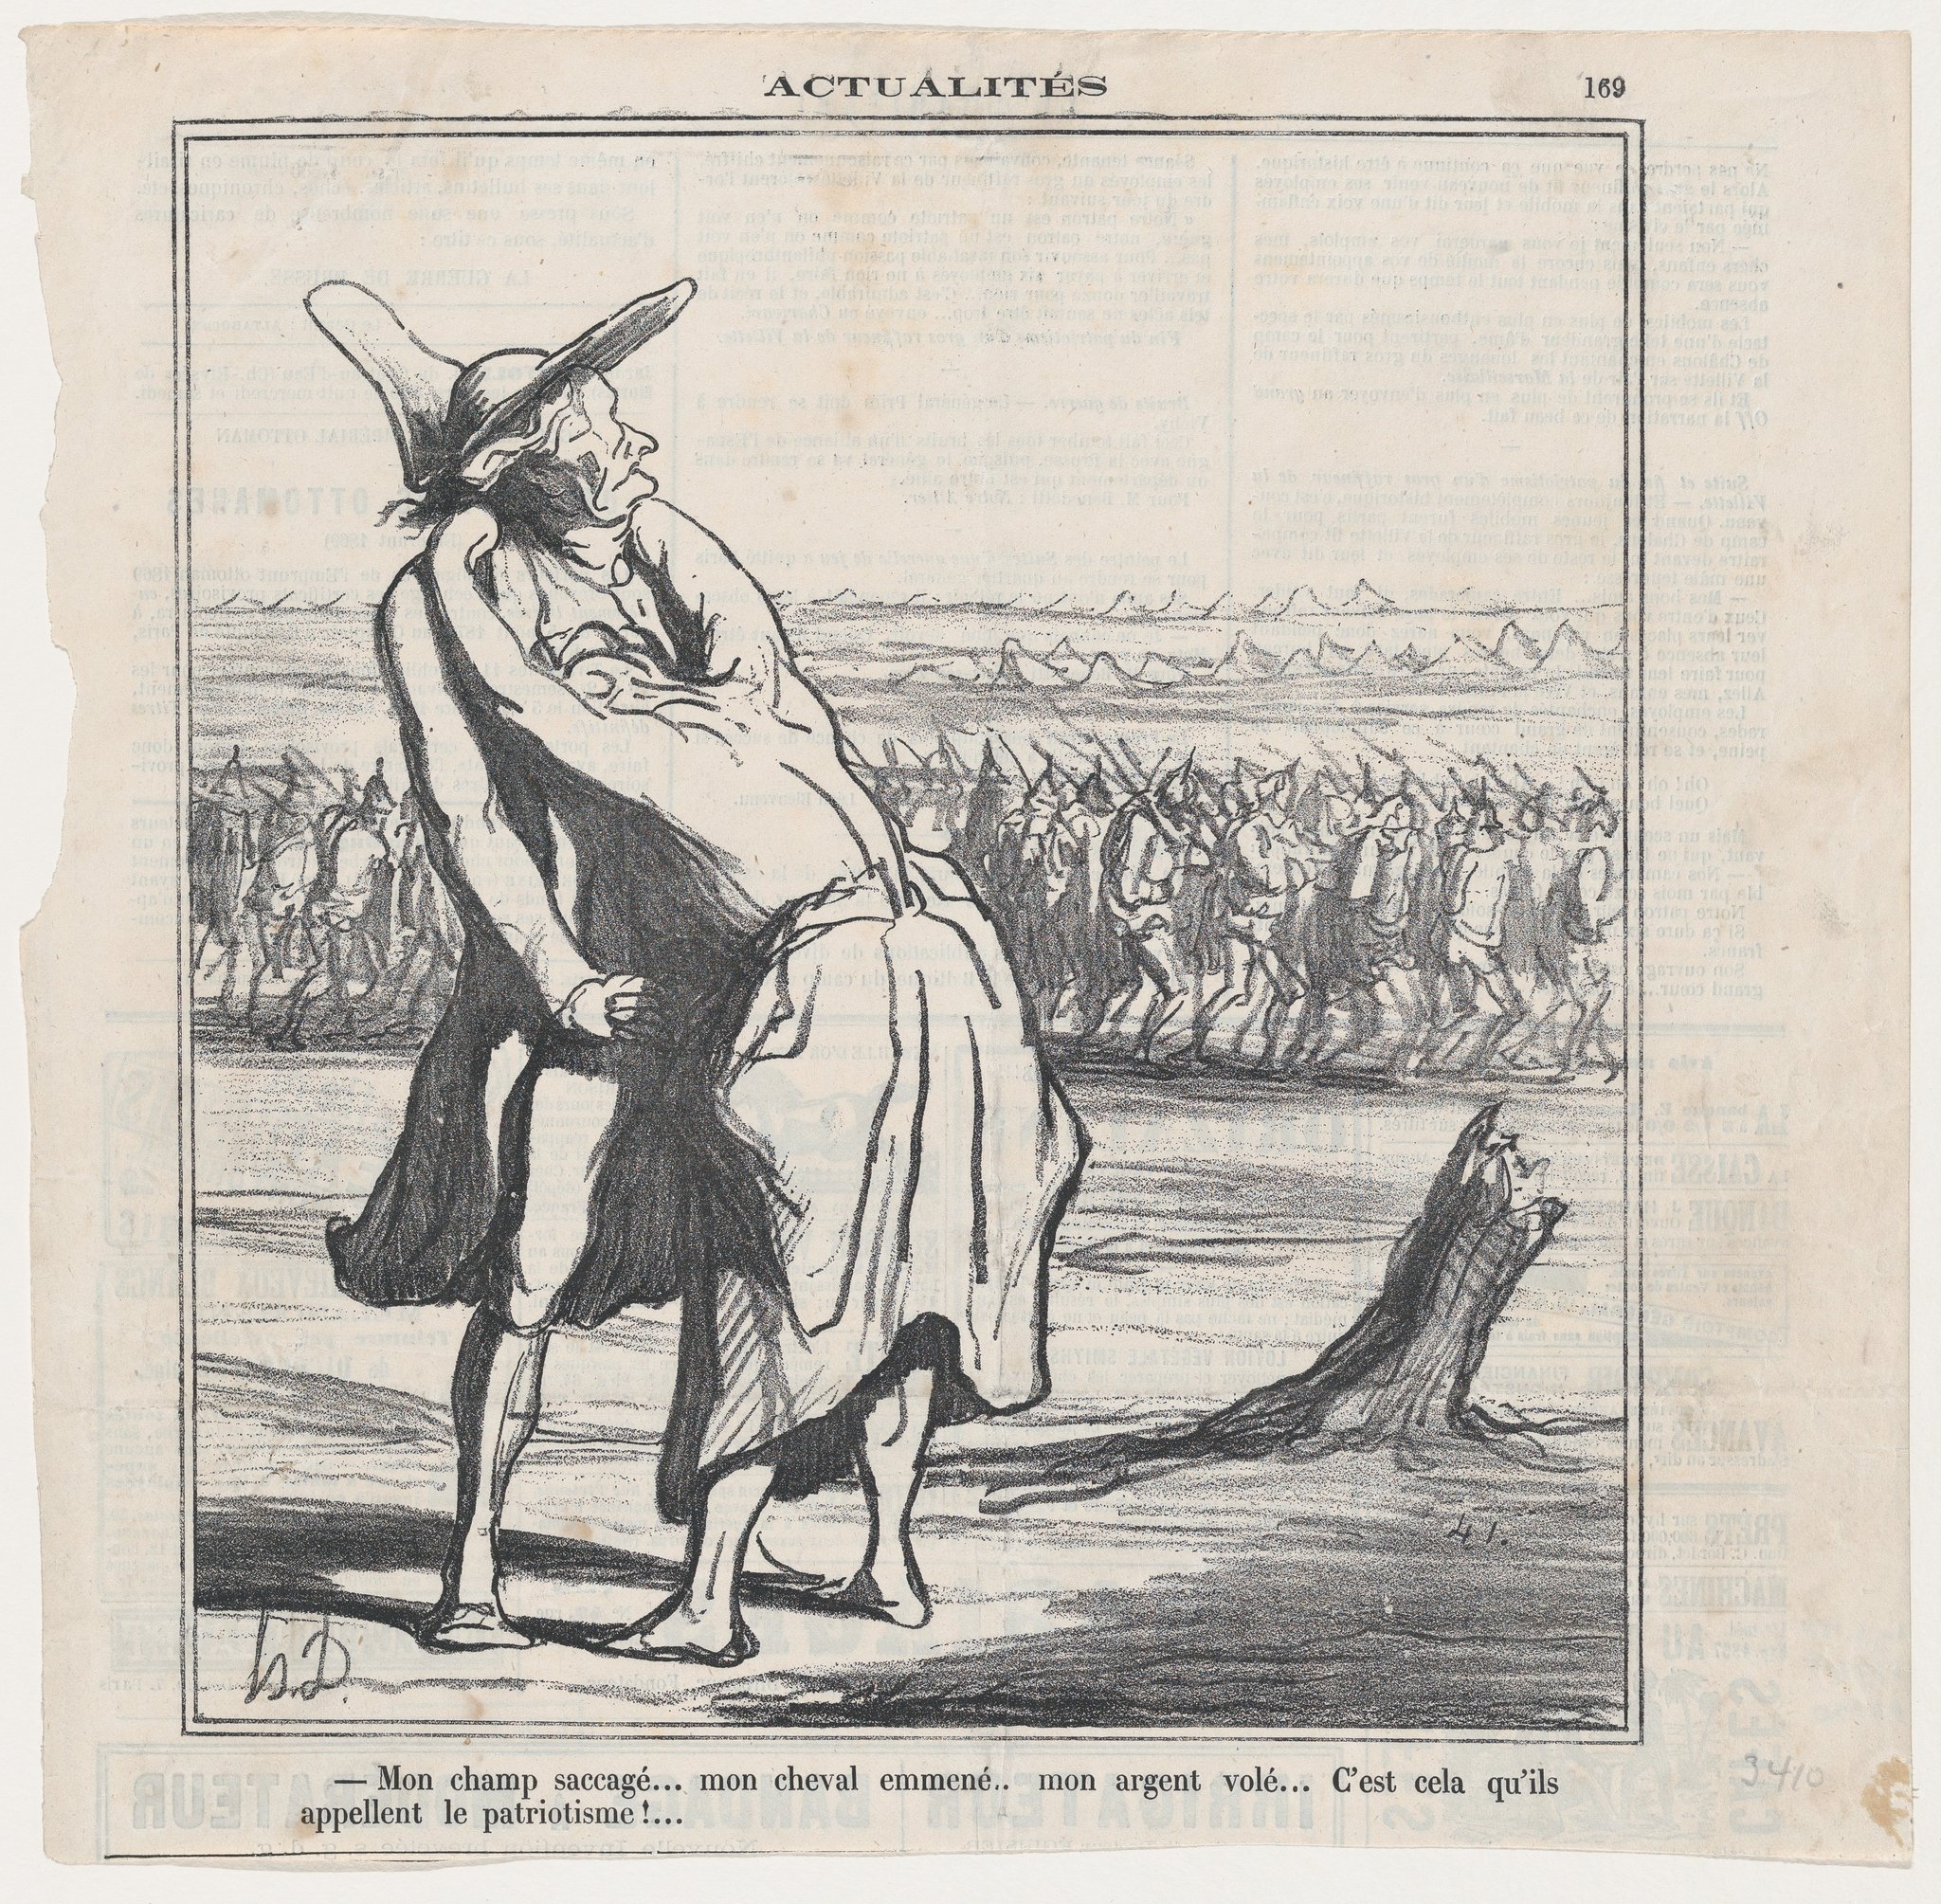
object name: print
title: My field plundered... my horse taken away... my money stolen... and this is what they call patriotism!..., from "News of the day"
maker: honoré daumier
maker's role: artist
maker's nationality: french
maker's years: 1808-1879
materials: paper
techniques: lithograph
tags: satire,soldiers,men